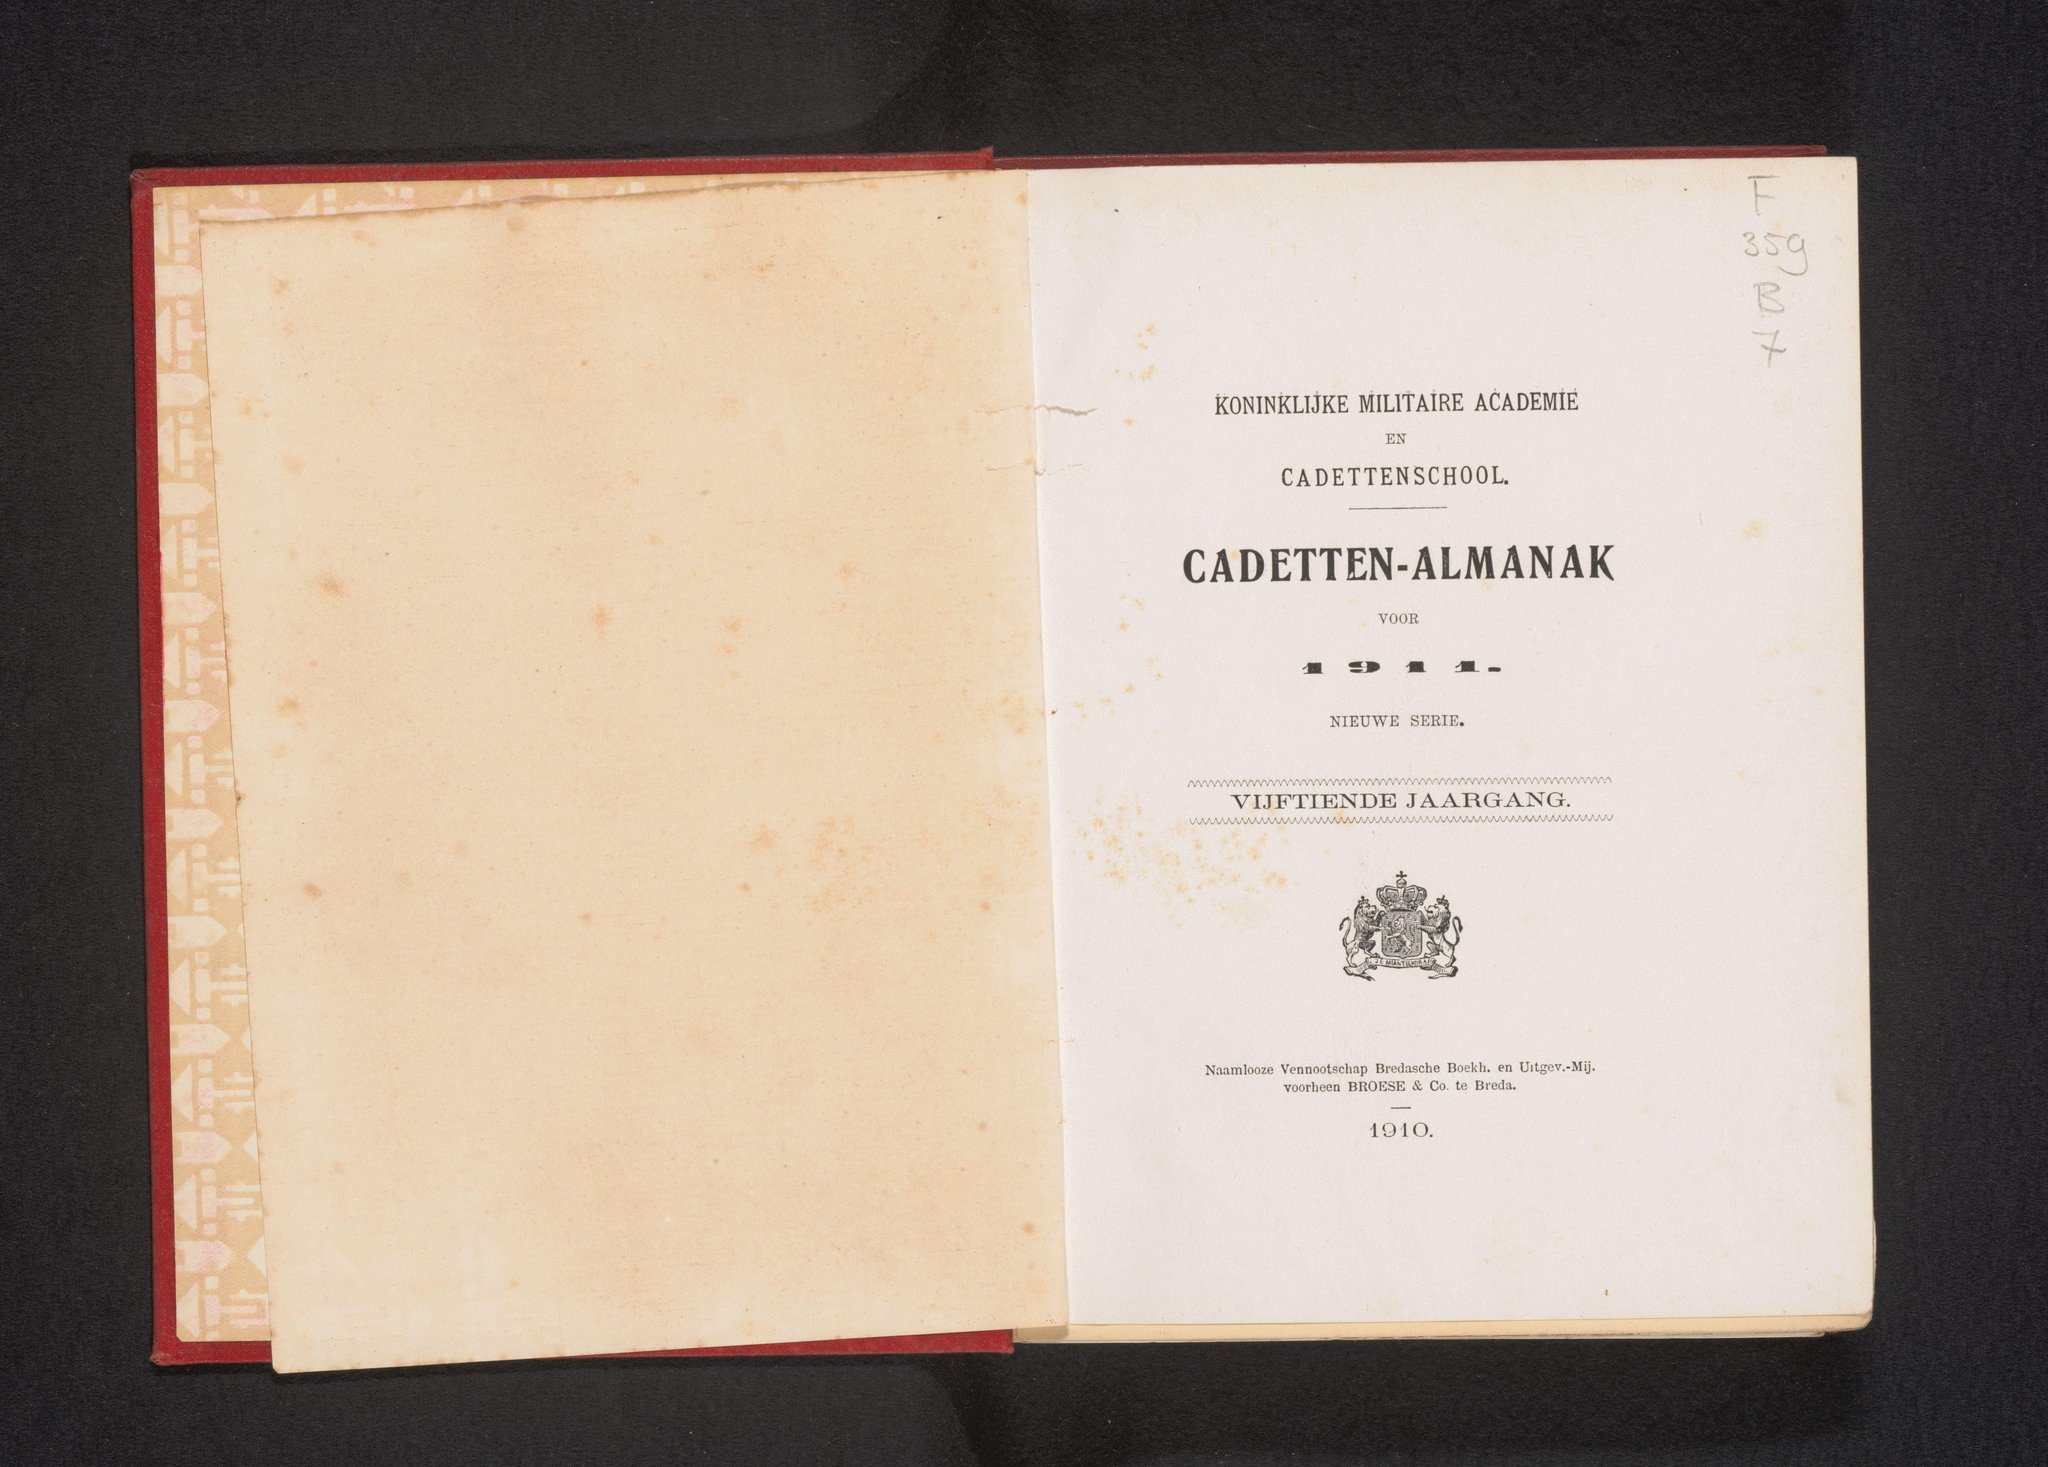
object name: book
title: Cadetten-almanak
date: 1910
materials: cardboard, linen, paper, photographic support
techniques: decorated paper, printing, salted paper print, engraving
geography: breda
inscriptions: name: ‘[.].C.J. Drost/ cadet Lt.l’